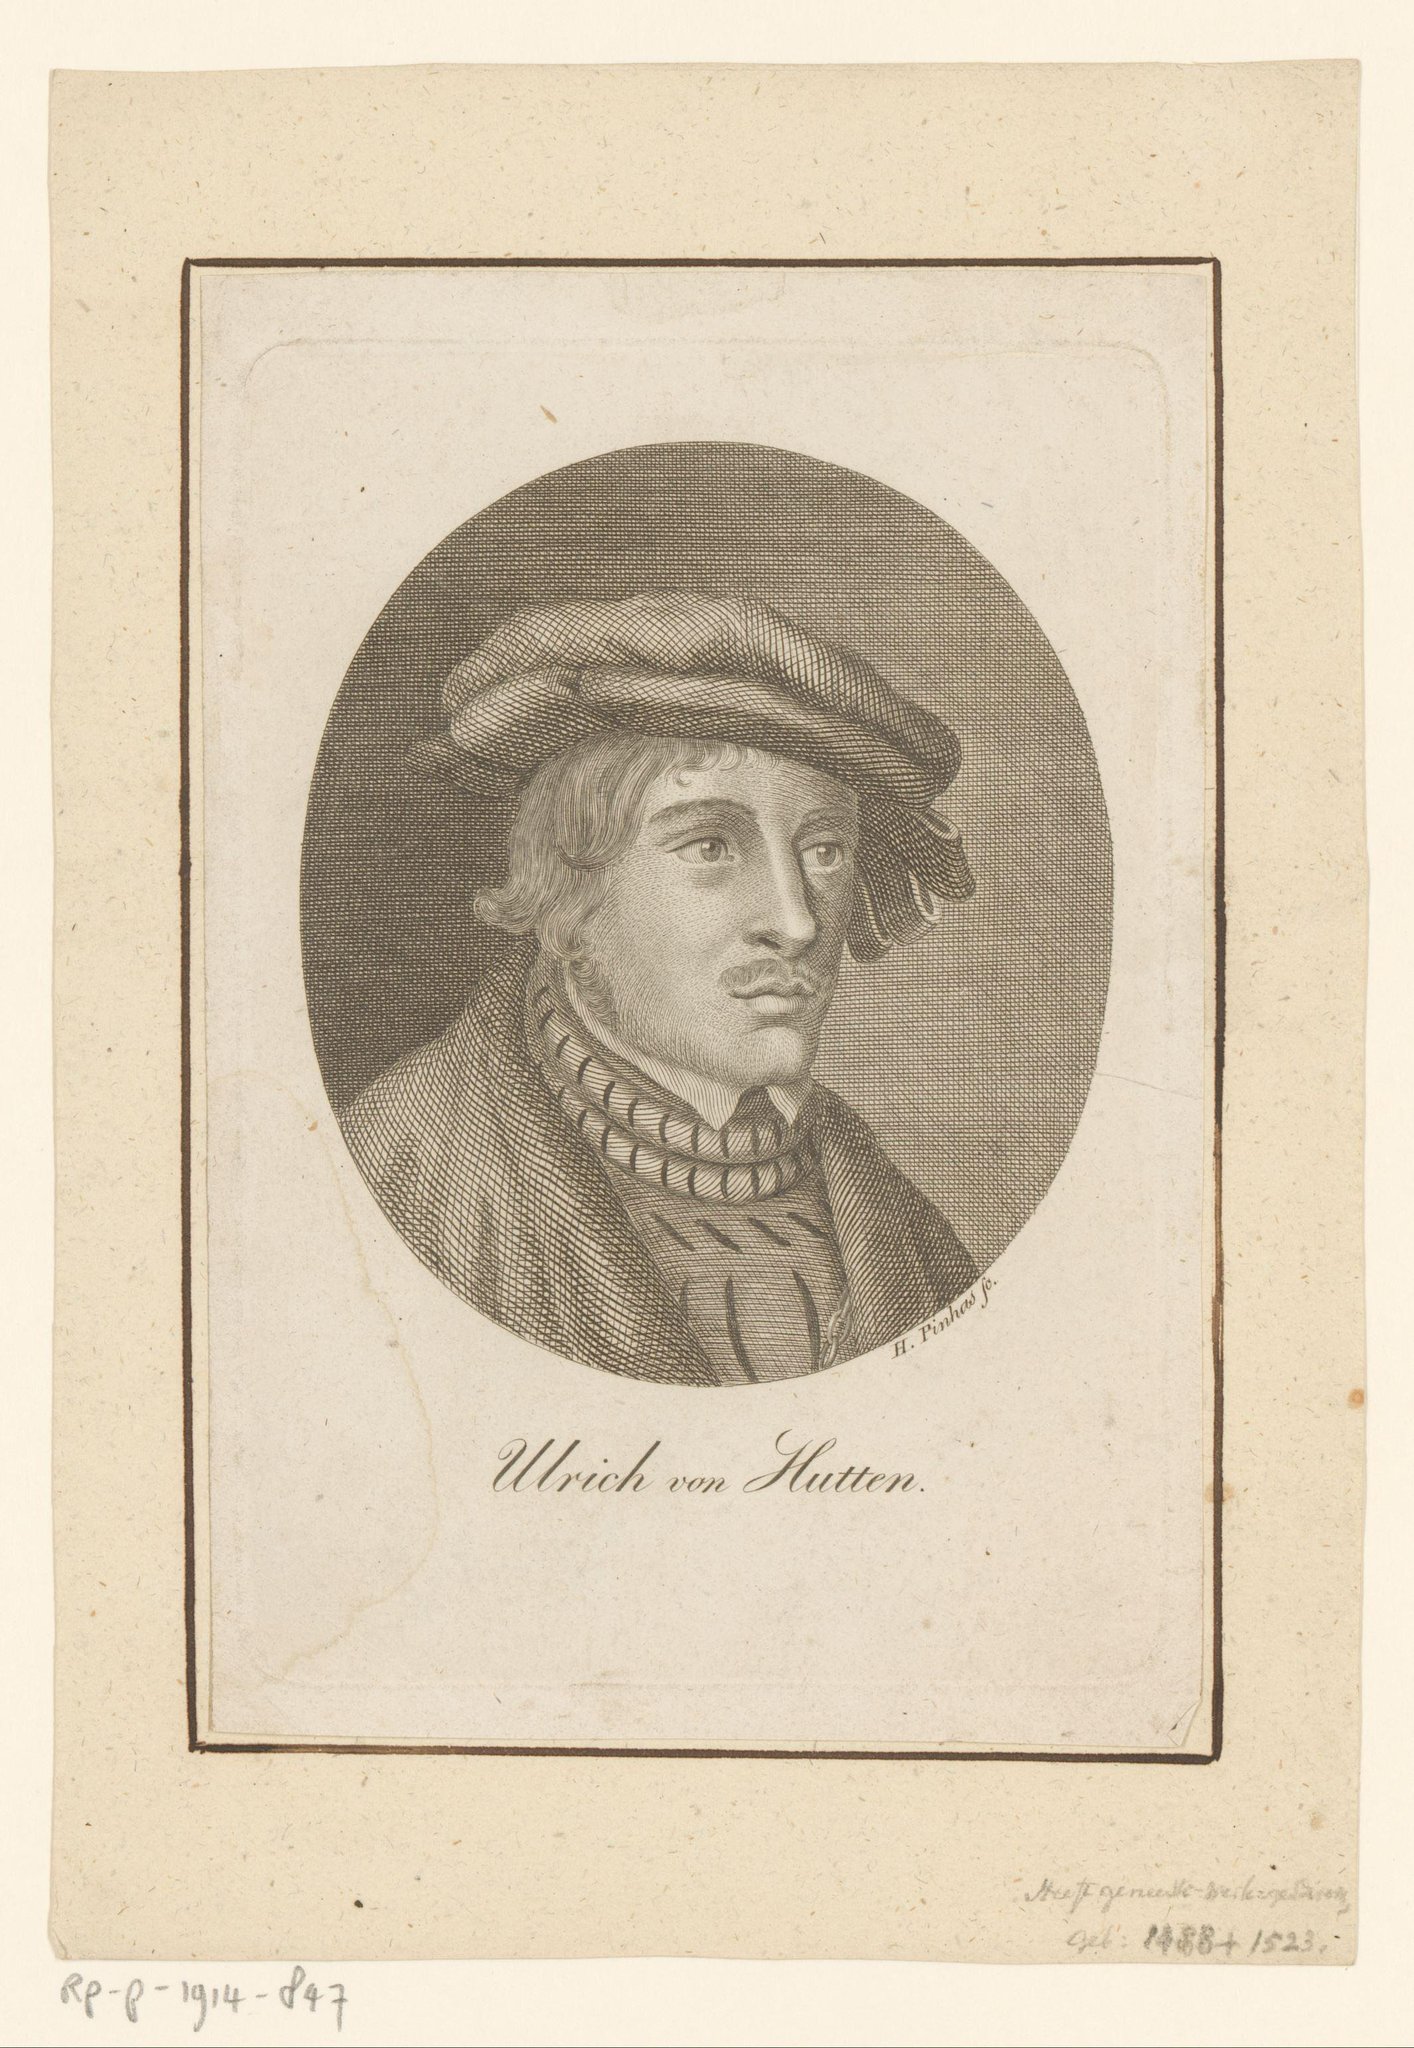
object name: print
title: Portret van Ulrich von Hutten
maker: hermann hirsch pinhas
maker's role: print maker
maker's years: 1795-1844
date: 1805-1844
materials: paper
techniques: engraving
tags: switzerland, politician, historical persons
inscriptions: collector's mark: Lugt 2228